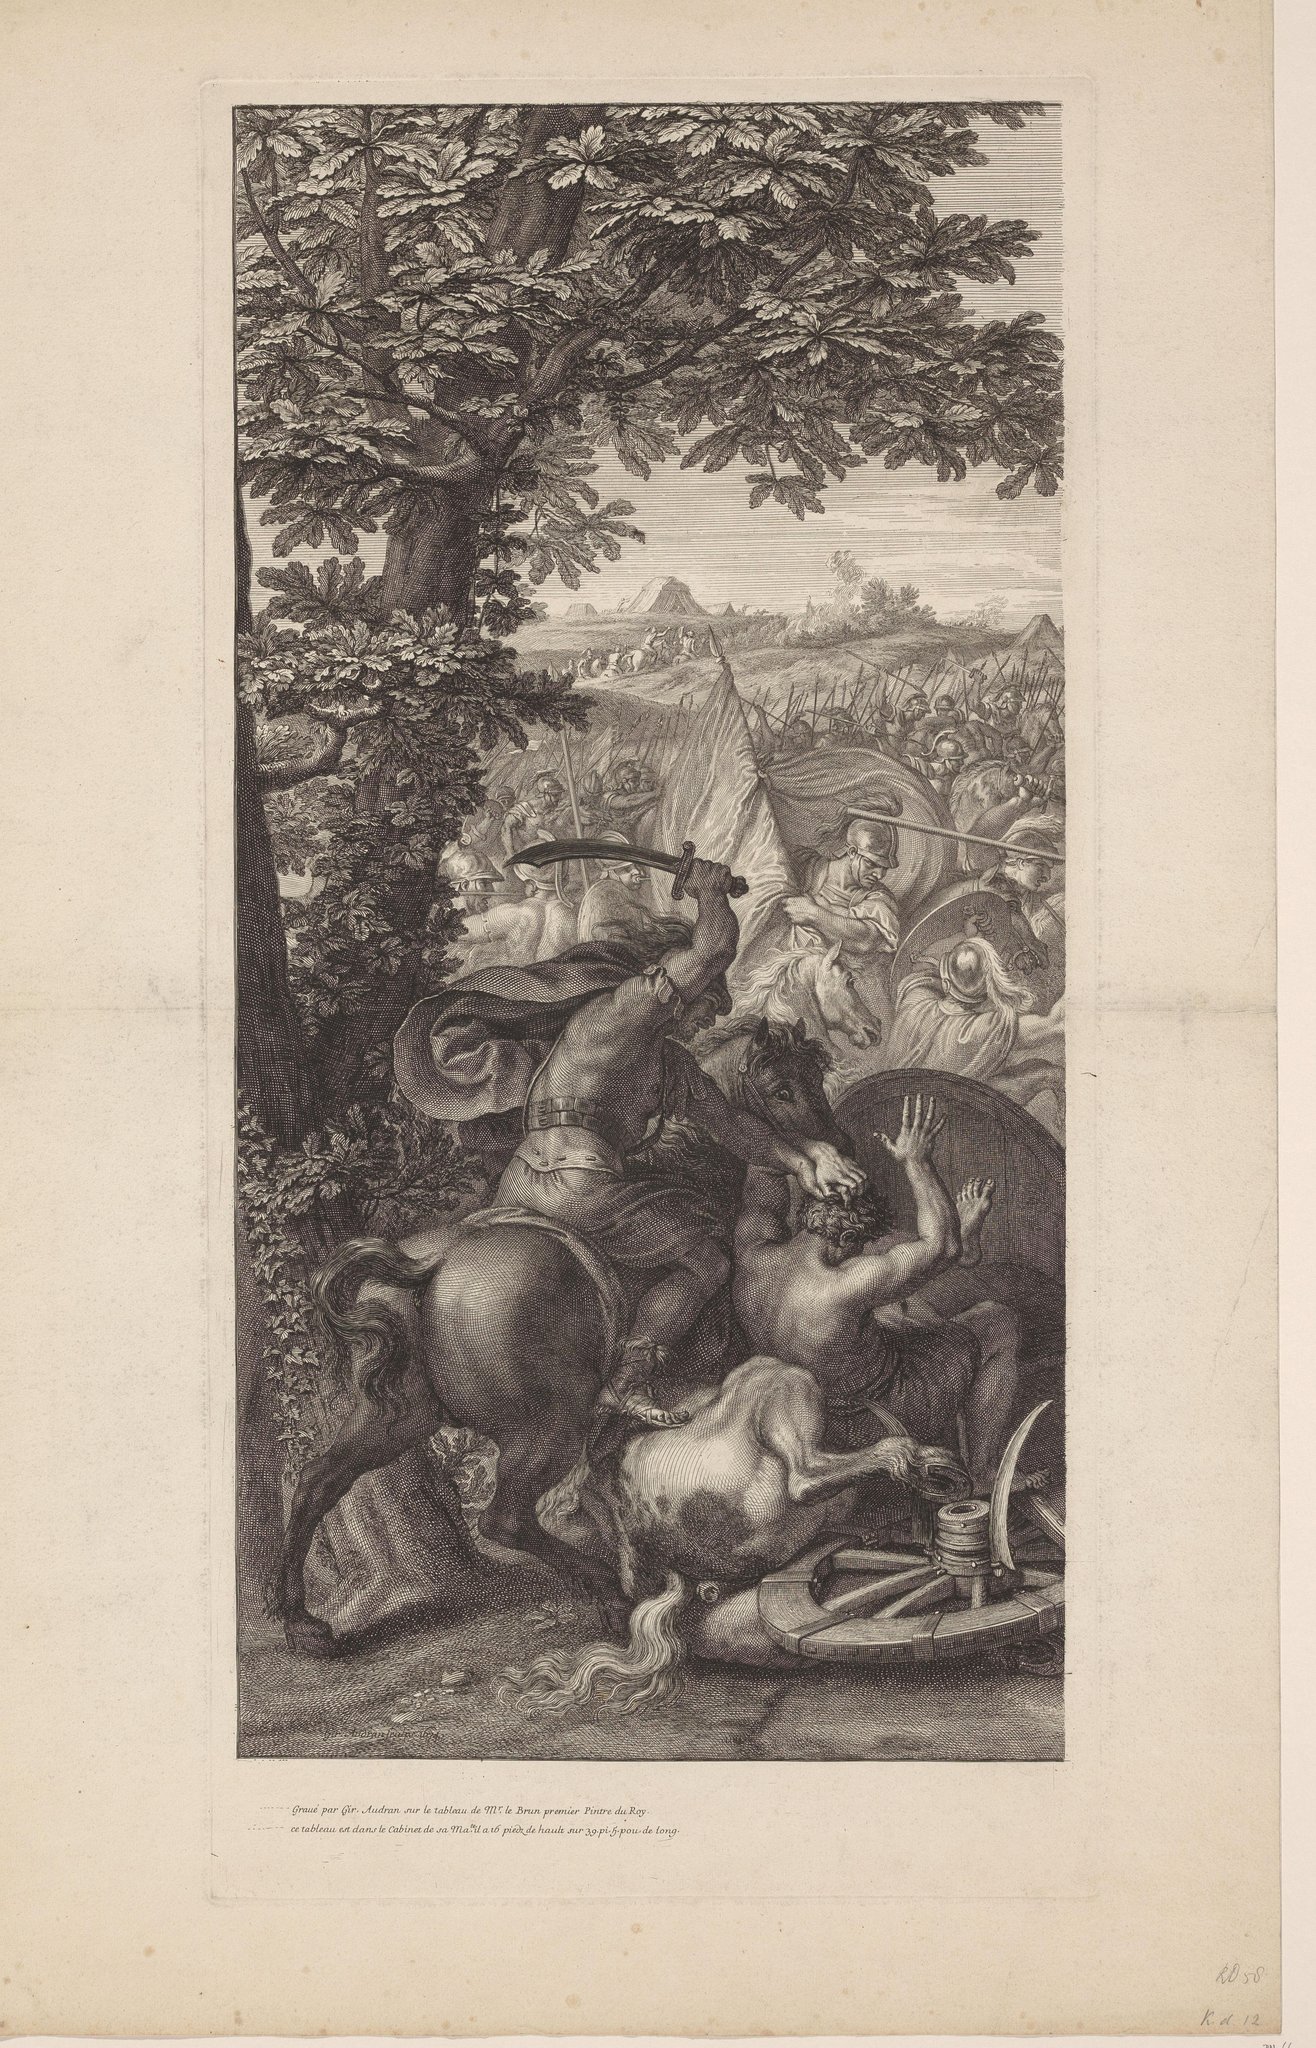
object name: print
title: Slag bij Arbela (plaat 1)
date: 1674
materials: paper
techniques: engraving, etching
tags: alexander fighting against darius at issus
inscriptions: inscription: ‘RD 58’, collector's mark: Lugt 1838, inscription: ‘K d 12’, collector's mark: Lugt 240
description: Eerste blad (van links naar rechts) van een prent gedrukt van vier platen.